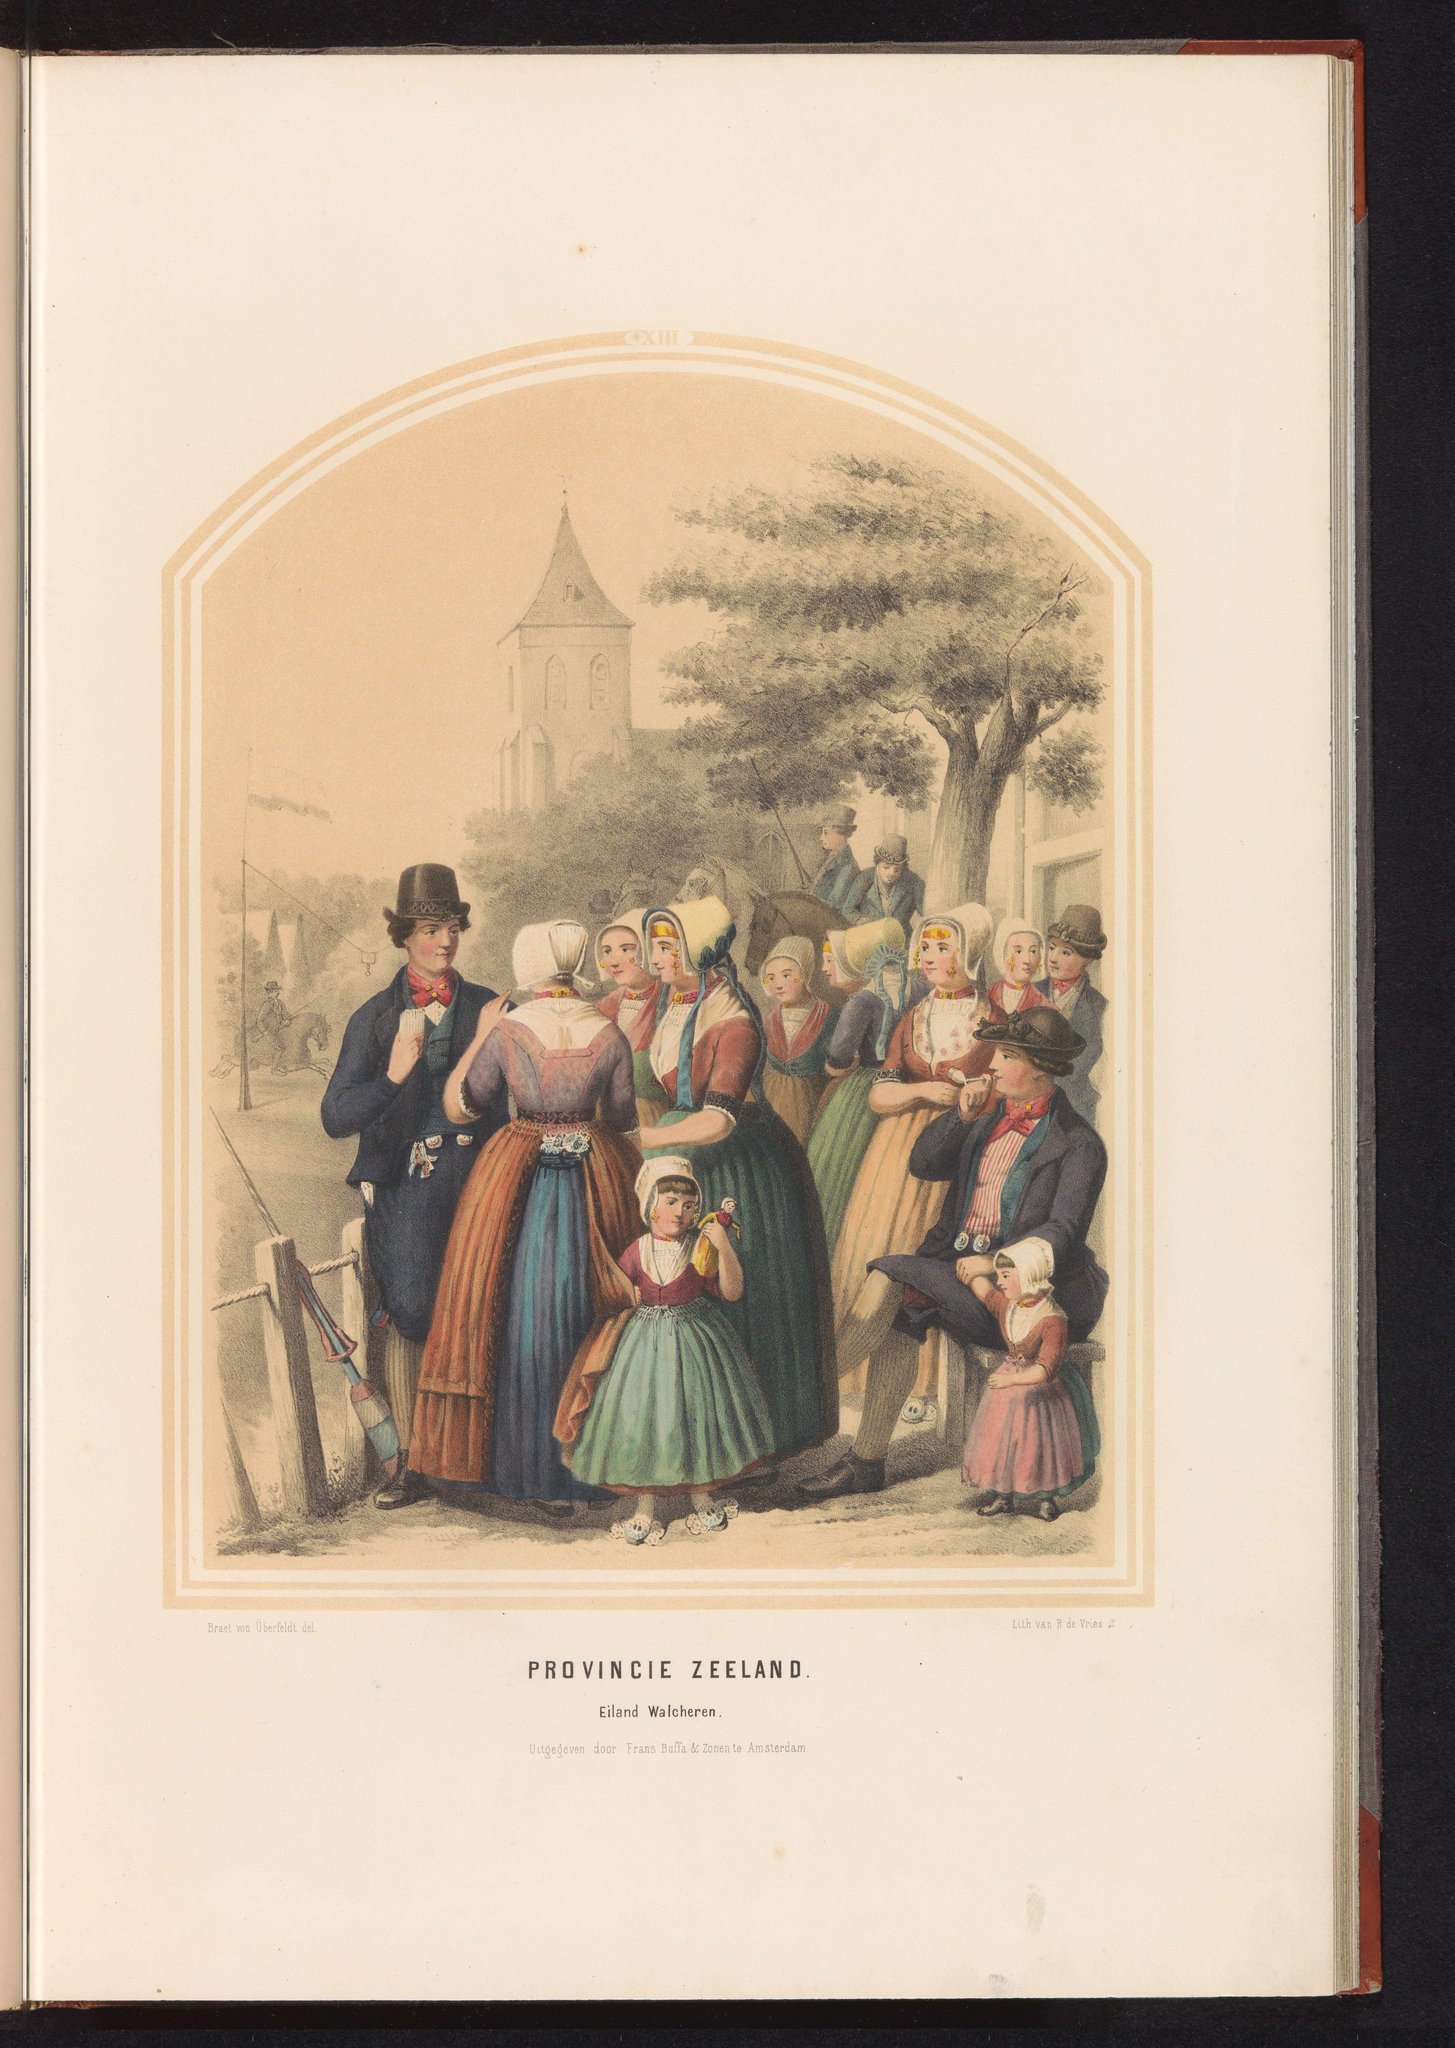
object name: print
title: Provincie Zeeland. Eiland Walcheren / XIII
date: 1857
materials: paper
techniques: hand coloring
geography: netherlands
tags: folk costume, regional costume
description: Klederdracht van het eiland Walcheren in de provincie Zeeland. Groep mensen bij wedstrijd ringsteken. Illustratie in een boek uit 1857 met 56 platen van Nederlandse klederdrachten.